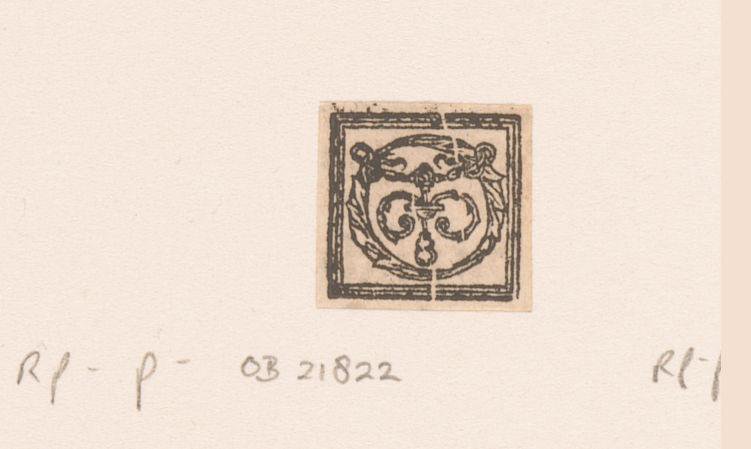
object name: book illustration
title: Letter O: ornament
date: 1556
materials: paper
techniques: letterpress printing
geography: zurich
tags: initial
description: Prent afkomstig uit: Bibel, die gantze, das ist alle Bücher alts und news Testaments (...). Zürich: Johann Froschauer, 1556.